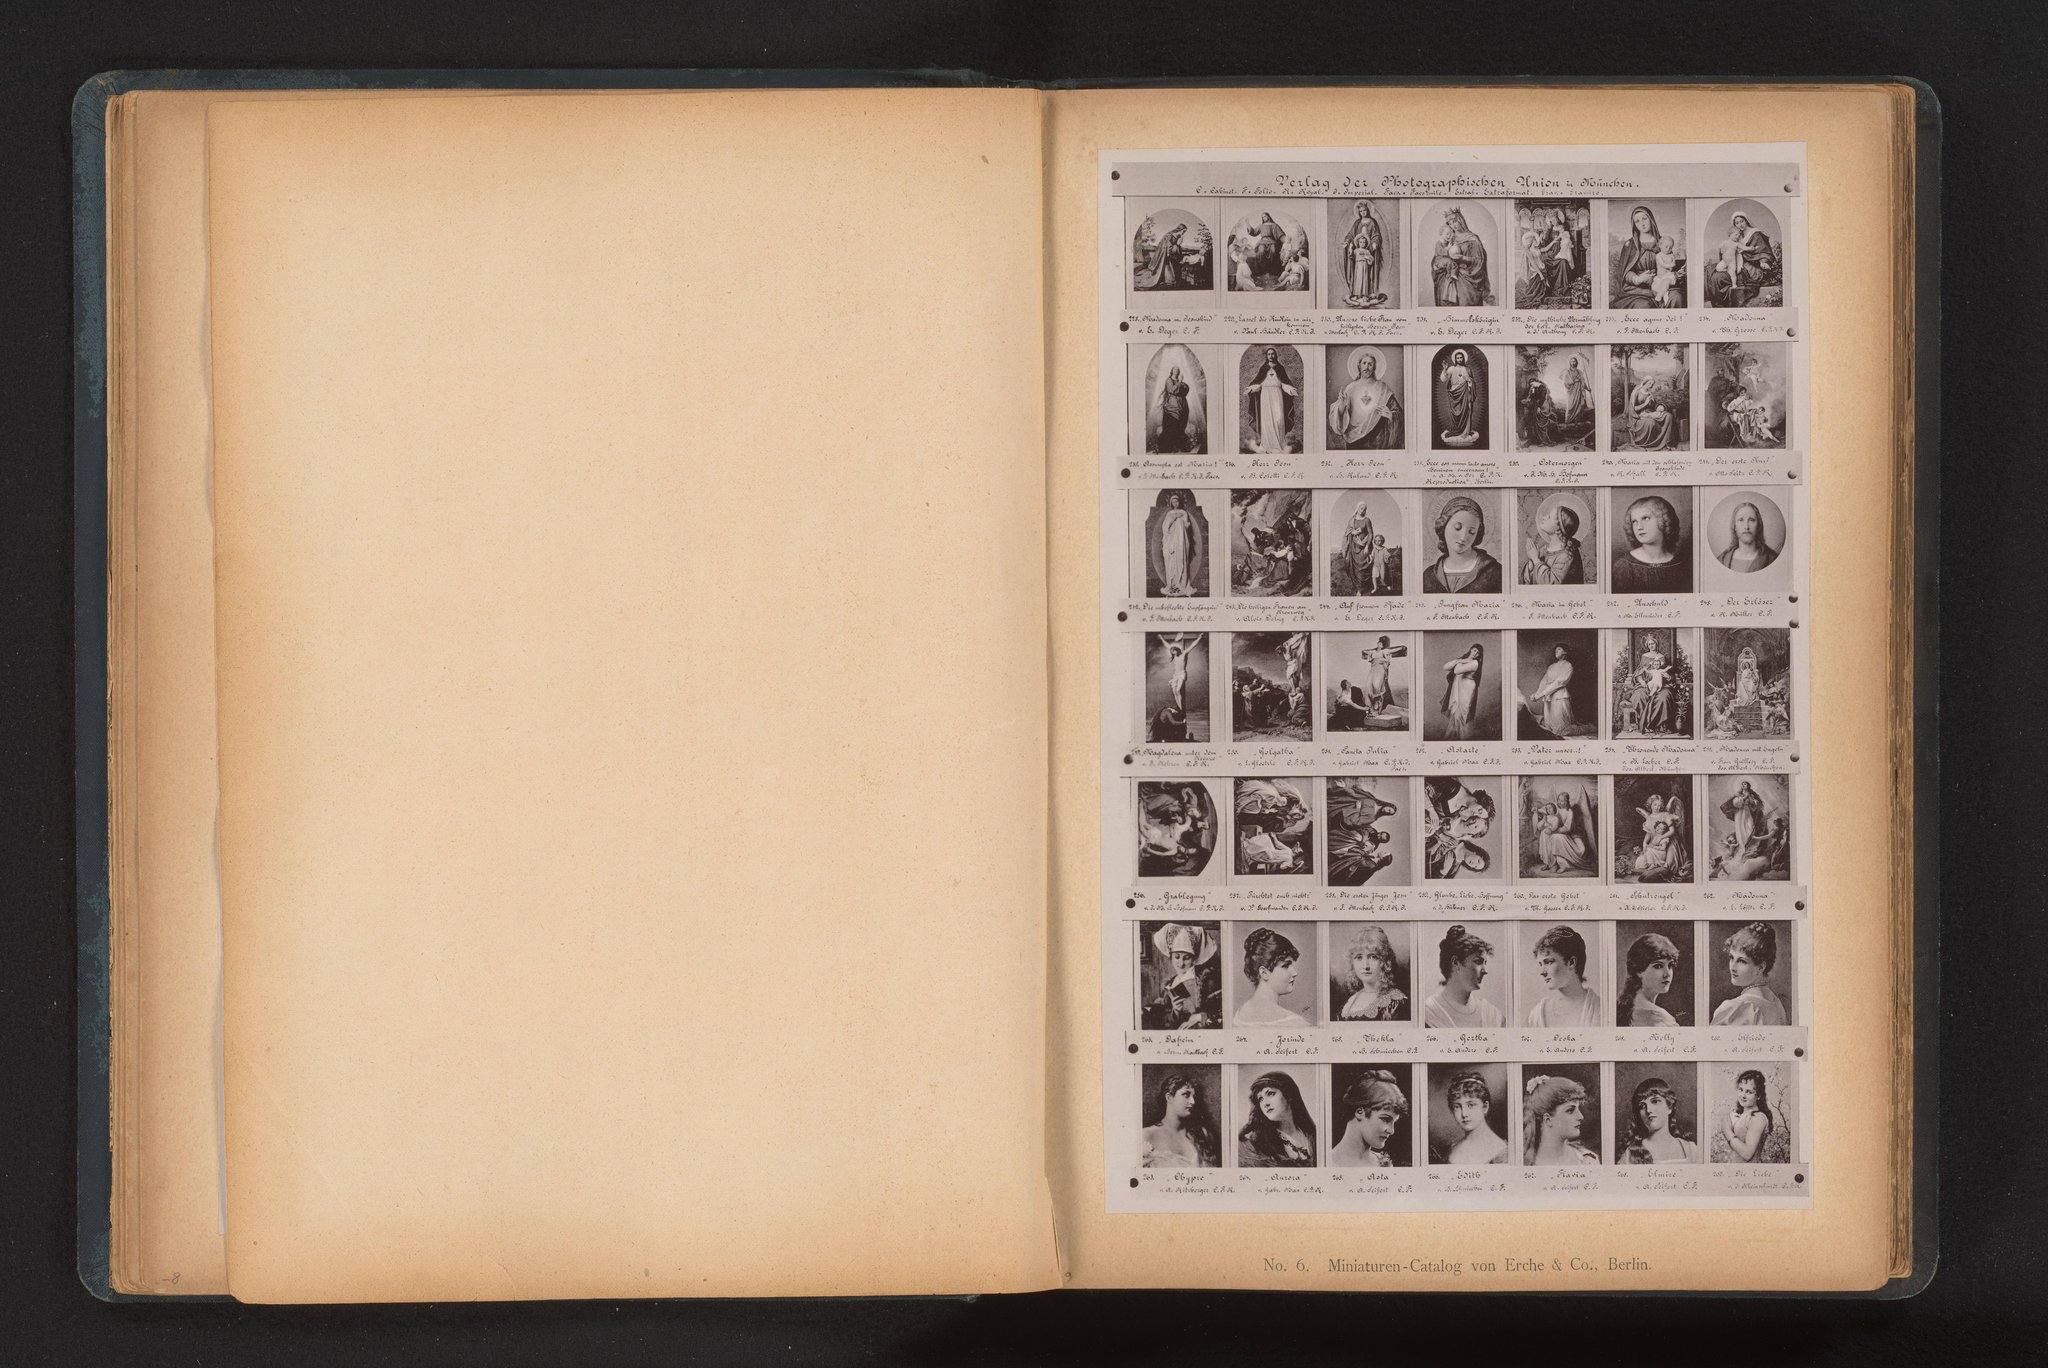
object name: page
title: Fotoreproducties van 49 geschilderde portretten van heiligen en onbekende vrouwen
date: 1880-1885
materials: paper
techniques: photograph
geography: berlin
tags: saints, anonymous historical person portrayed - bb - woman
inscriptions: number: ‘No. 6.’